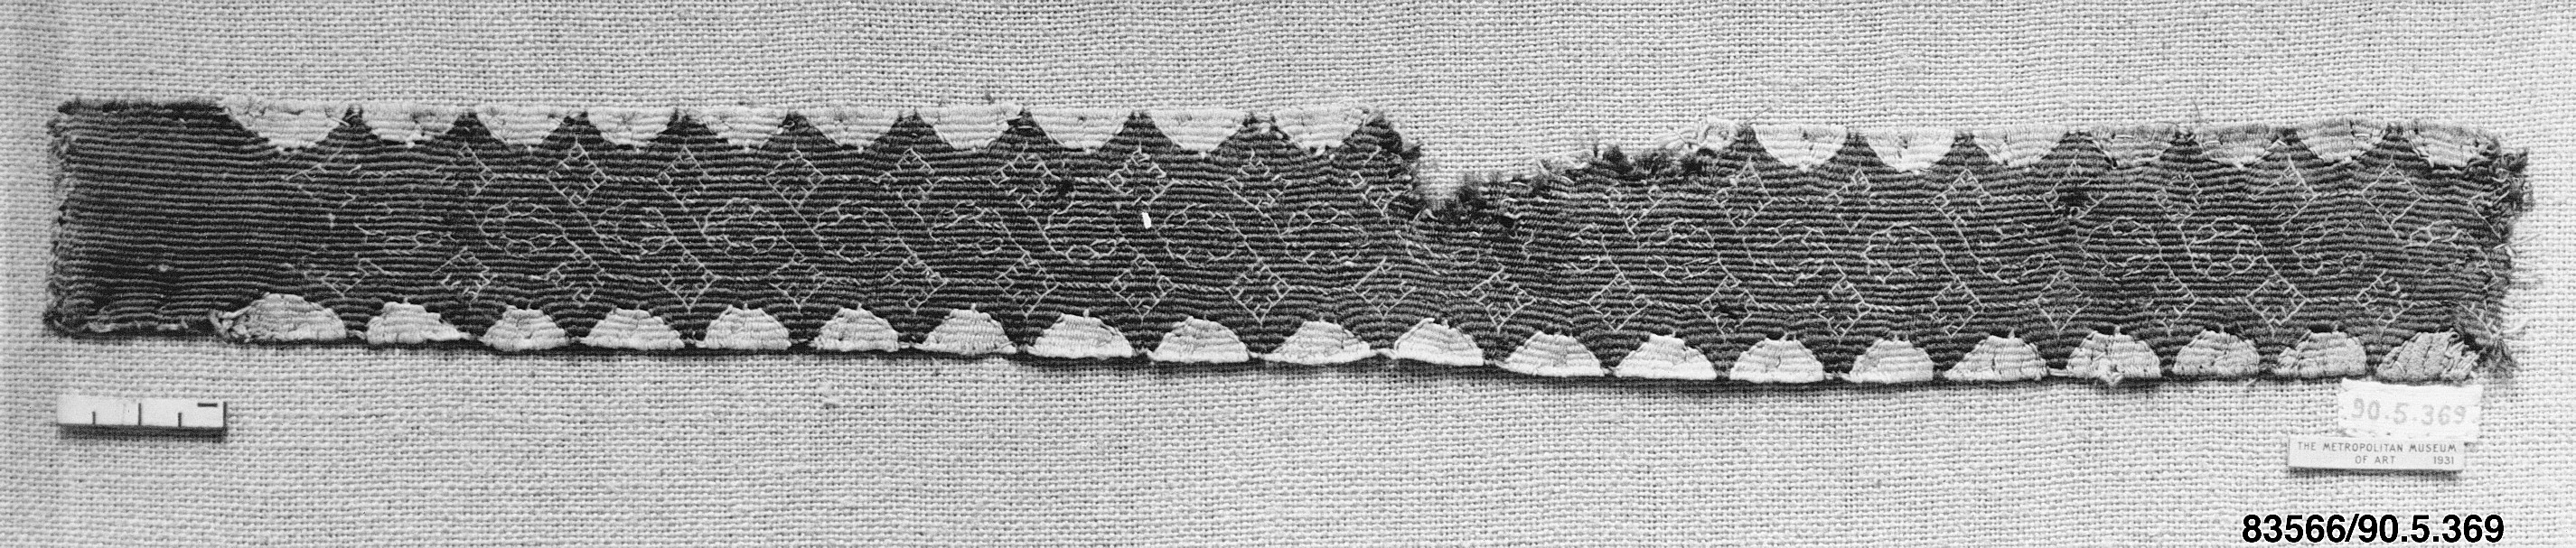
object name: textile fragment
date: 201-400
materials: linen, wool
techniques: weave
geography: egypt